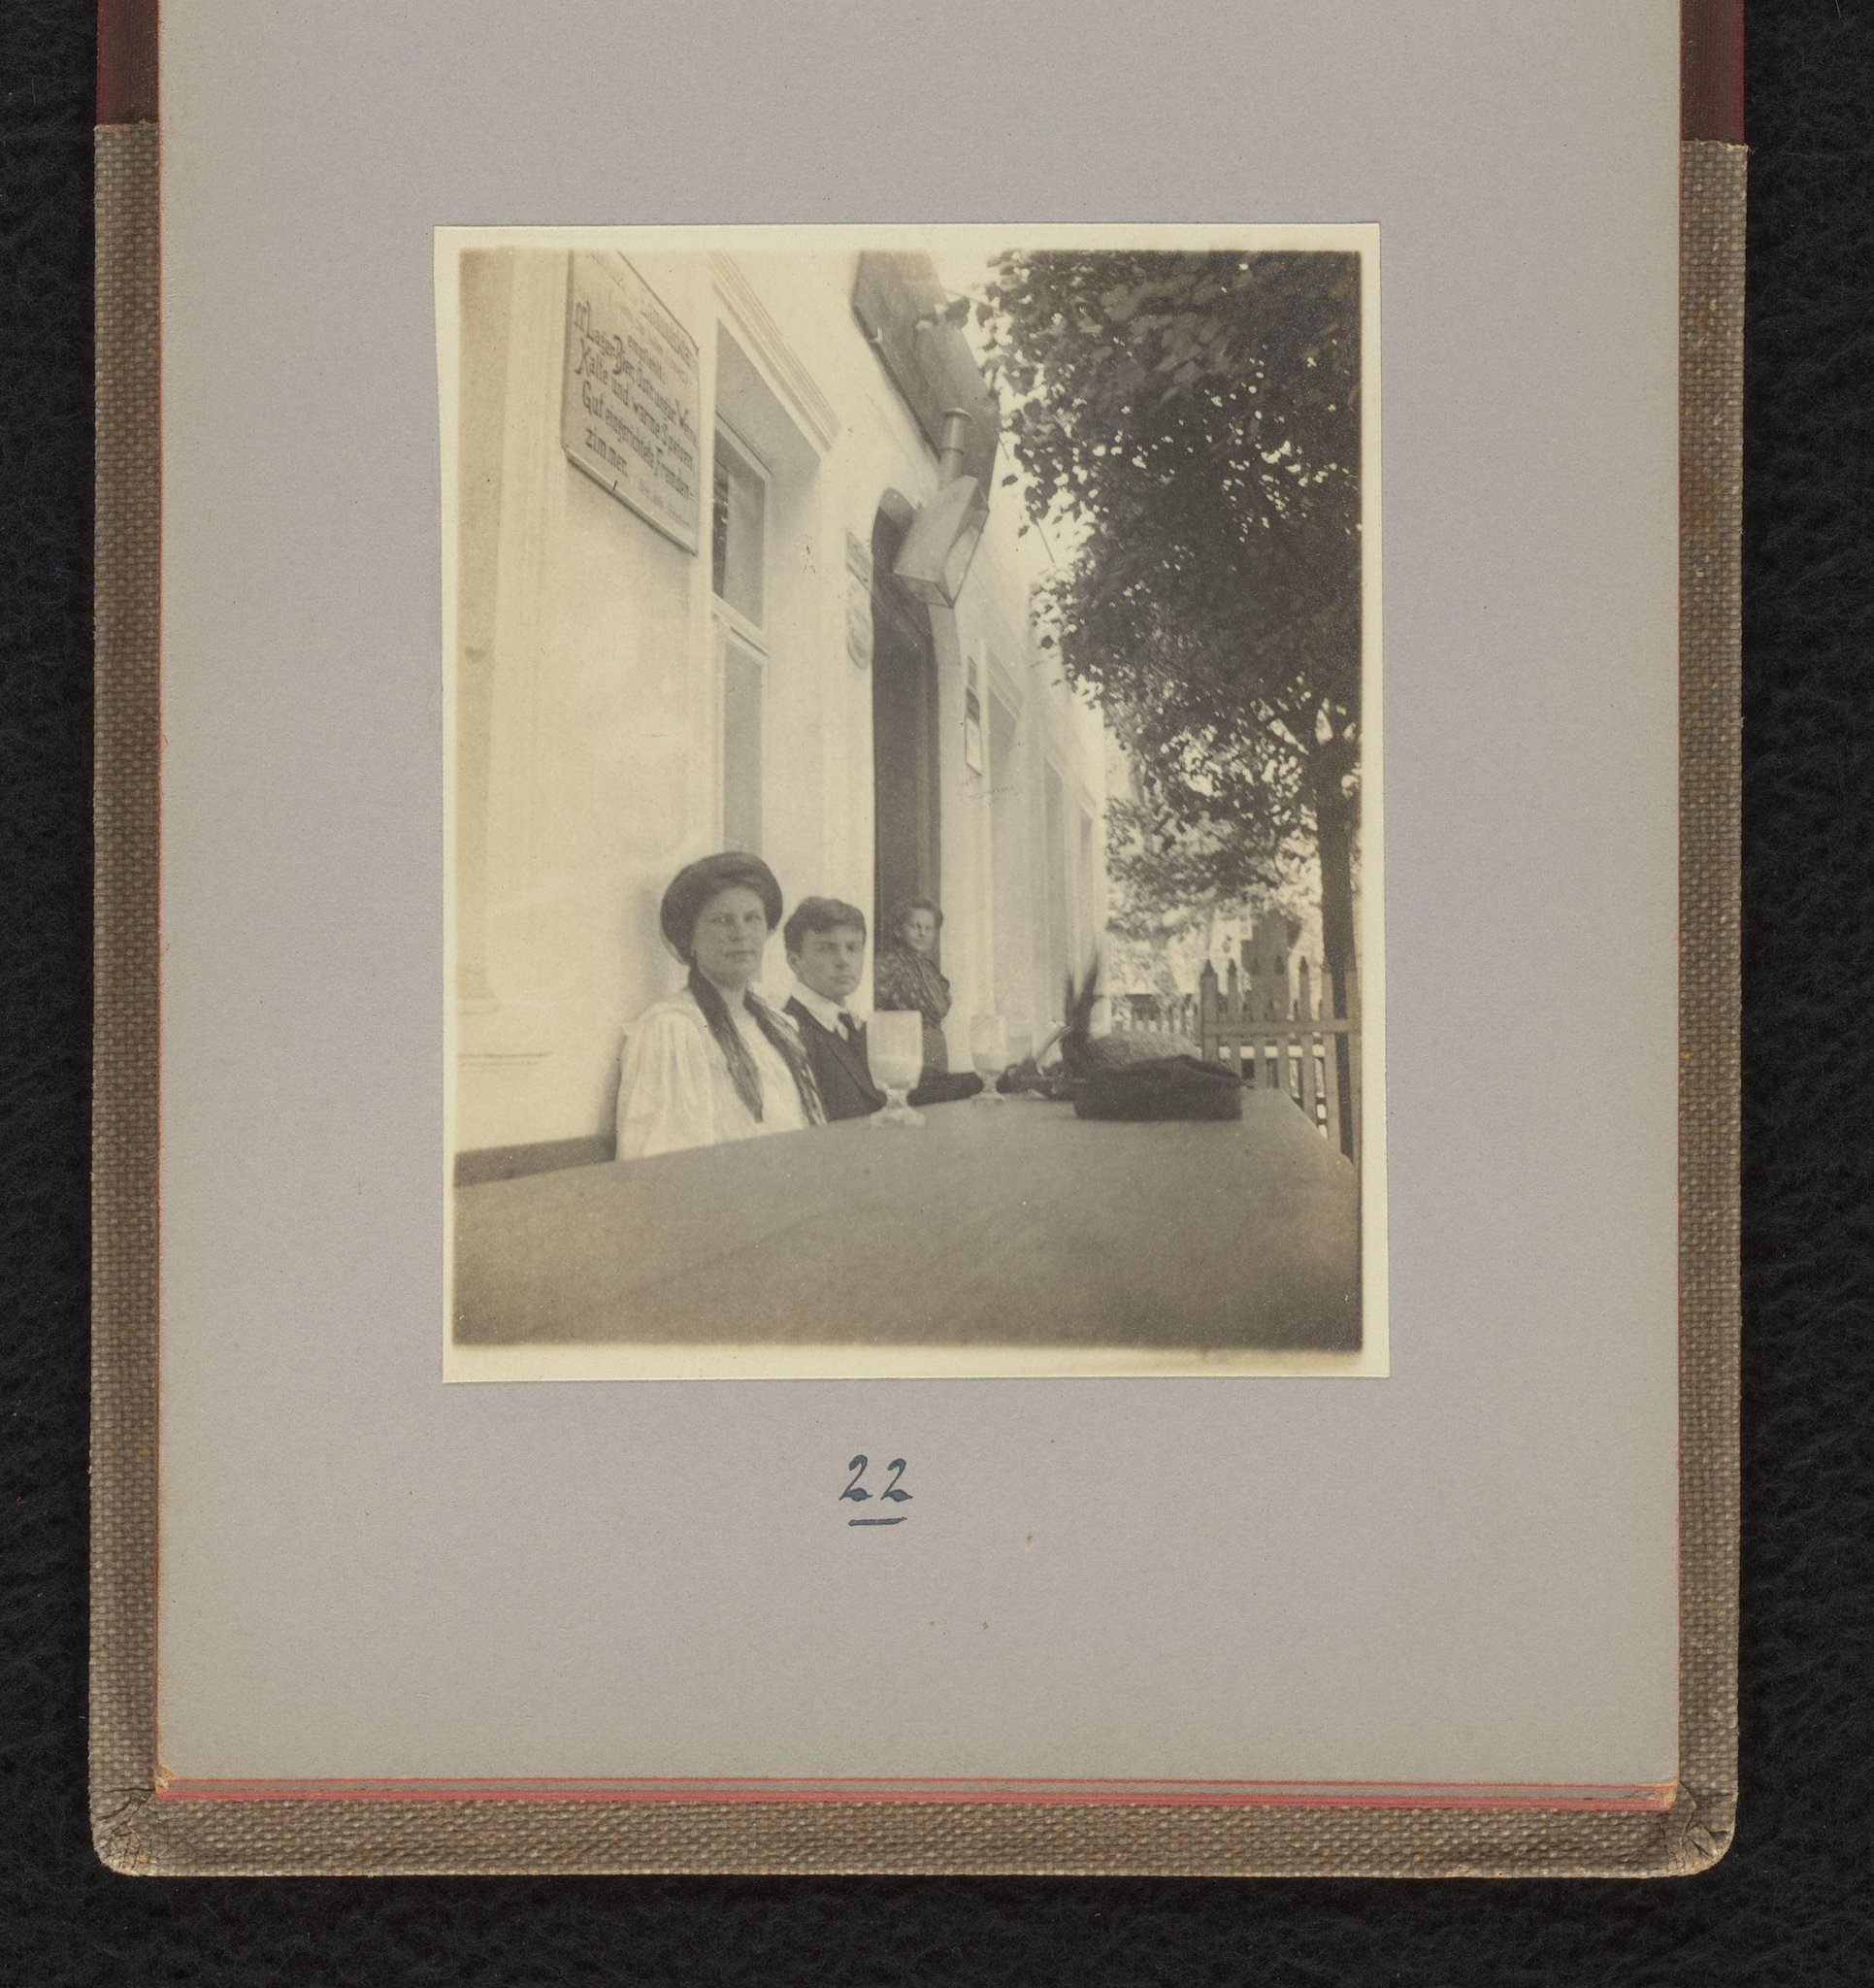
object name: photograph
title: Johnsdorf - "melk is goed voor elk"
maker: hermann johannes kessler (boelie)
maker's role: voetballer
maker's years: 1896-1971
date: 1910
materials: paper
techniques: gelatin silver print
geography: jonsdorf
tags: johan herman kessler (jan), pavement, terrace in front of inn or restaurant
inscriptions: number: ‘22’